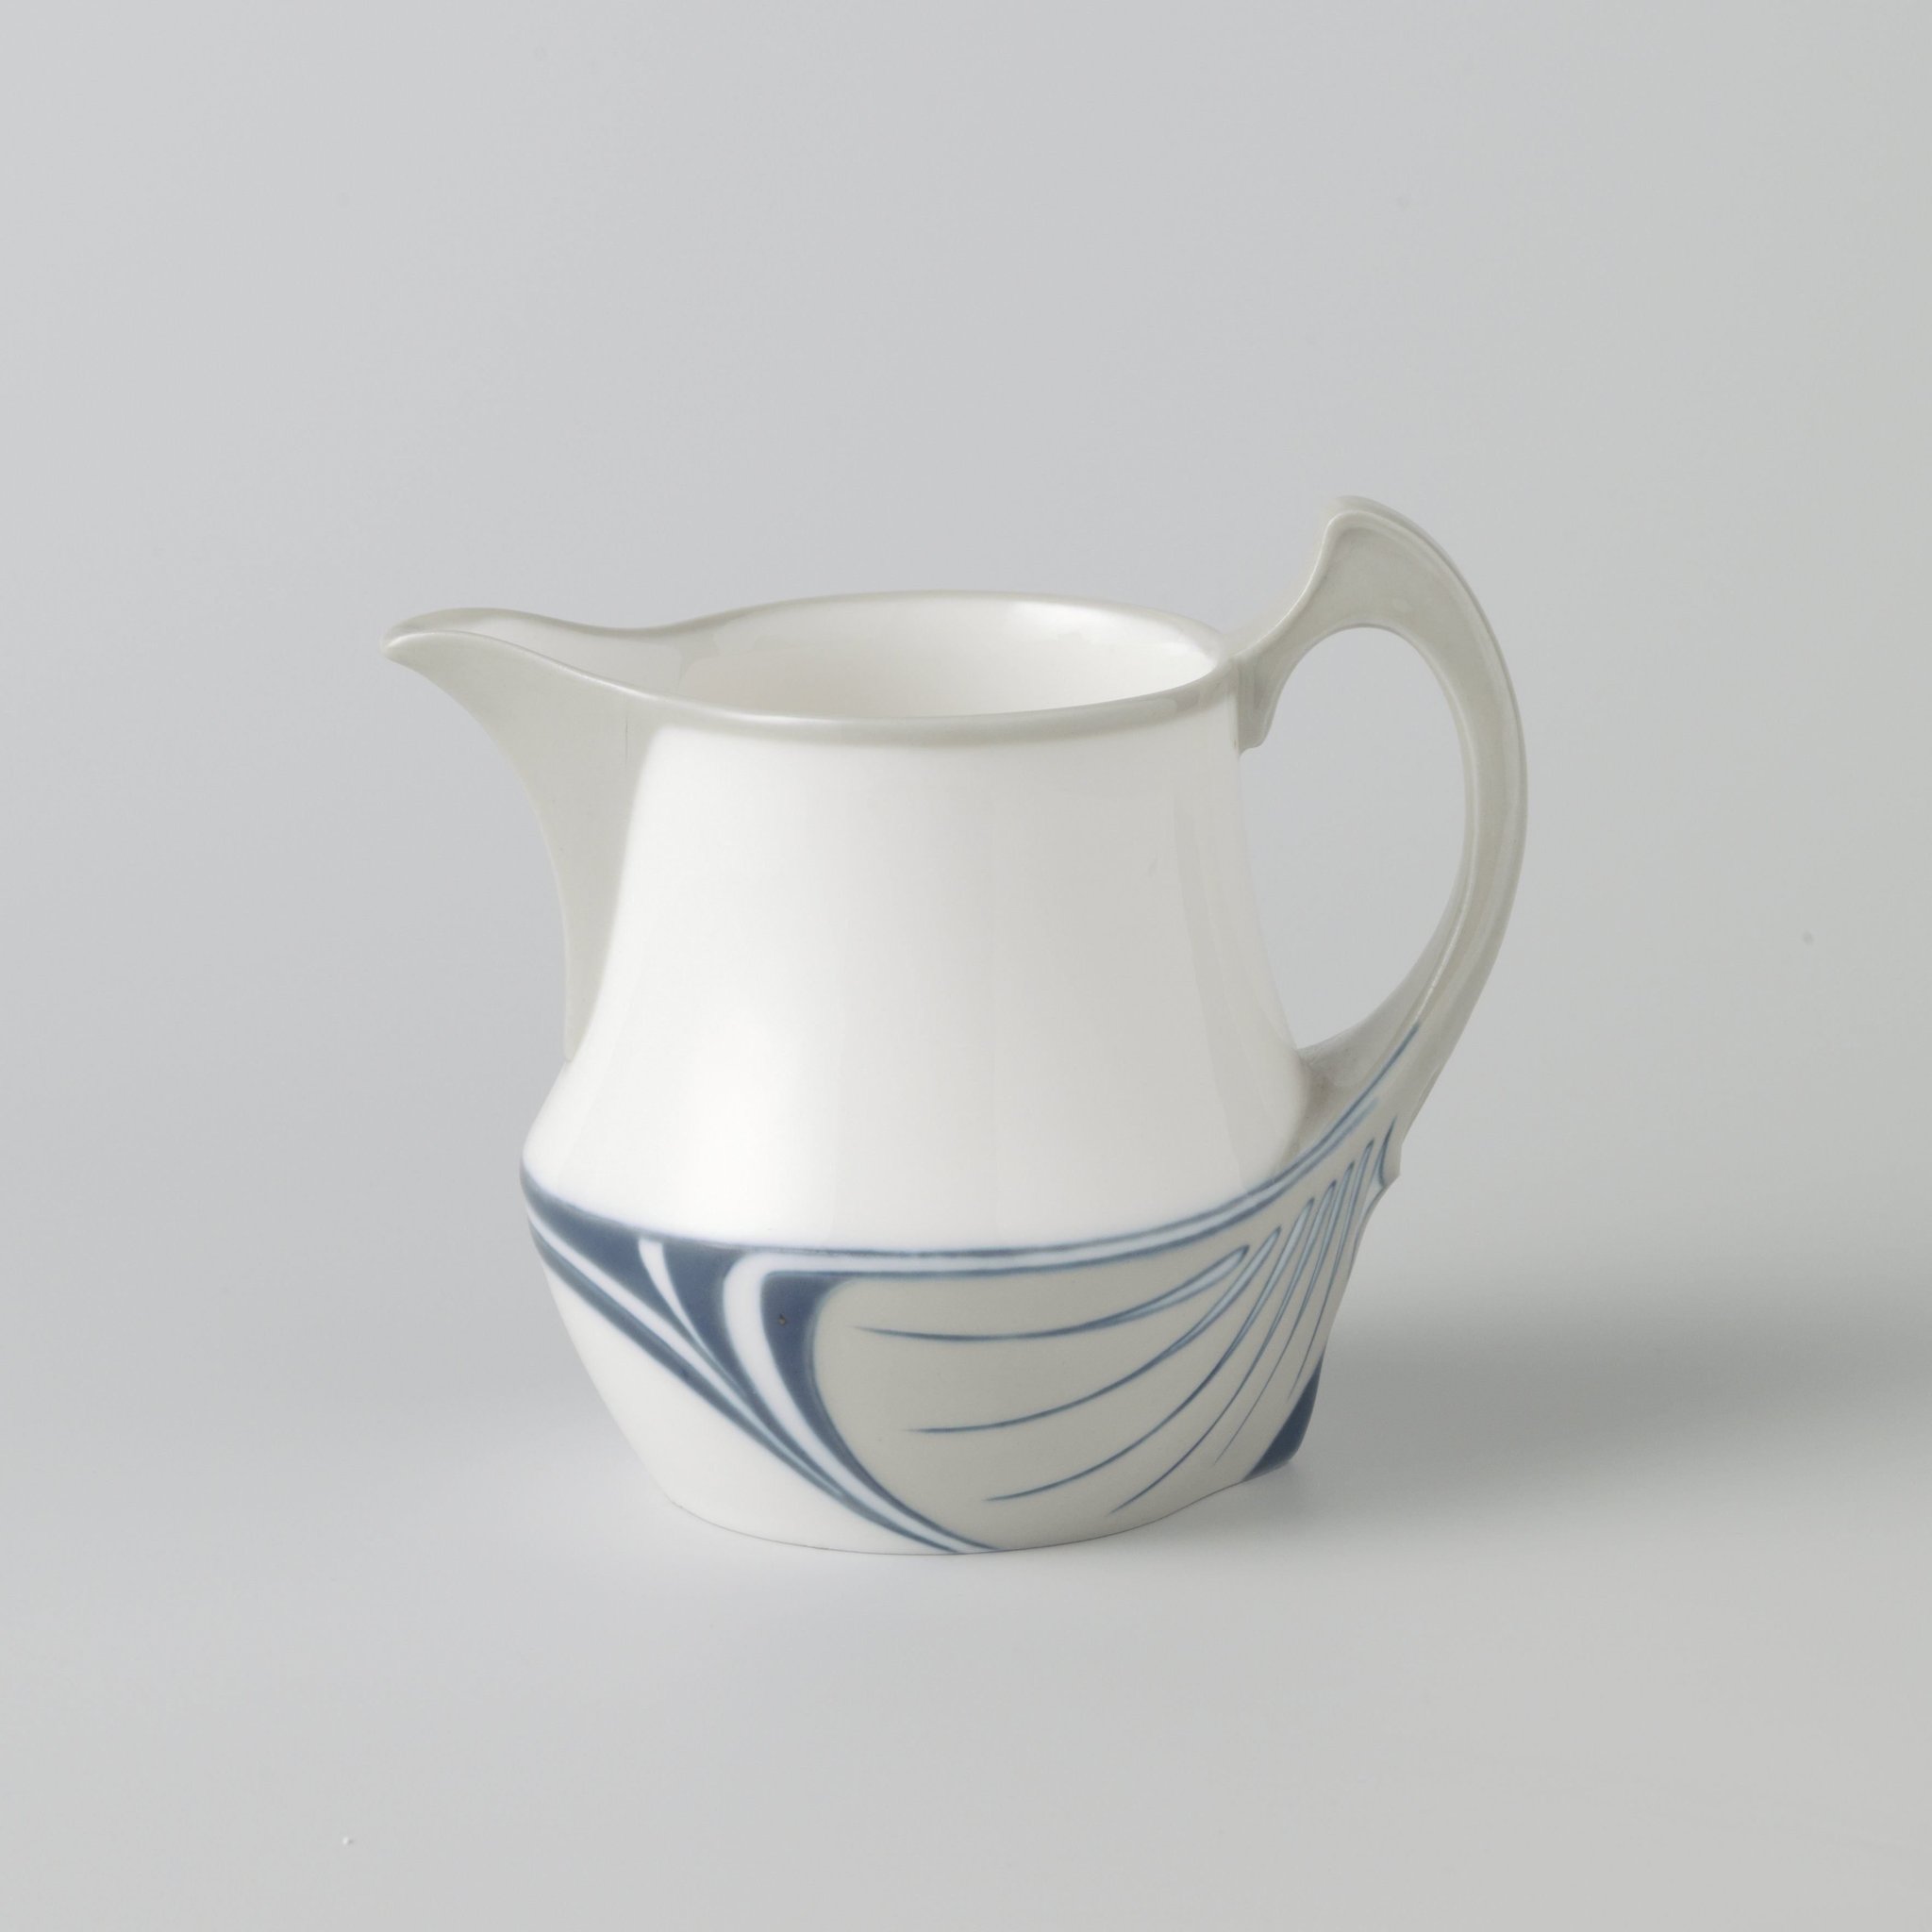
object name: eating drinking utensil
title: Melkkan uit het koffie- en theeservies 'Saxonia'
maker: otto eduard voigt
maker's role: keramiekontwerper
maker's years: 1870-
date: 1904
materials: porcelain, chemical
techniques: painted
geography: meissen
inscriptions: model number: ‘U 153’, mark: ‘61’, factory mark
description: Parts of a tea and coffee service. Porcelain. Meissen, Königlich Sächsische Porzellanmanufaktur, 1904, designed by Otto Eduard Voigt.